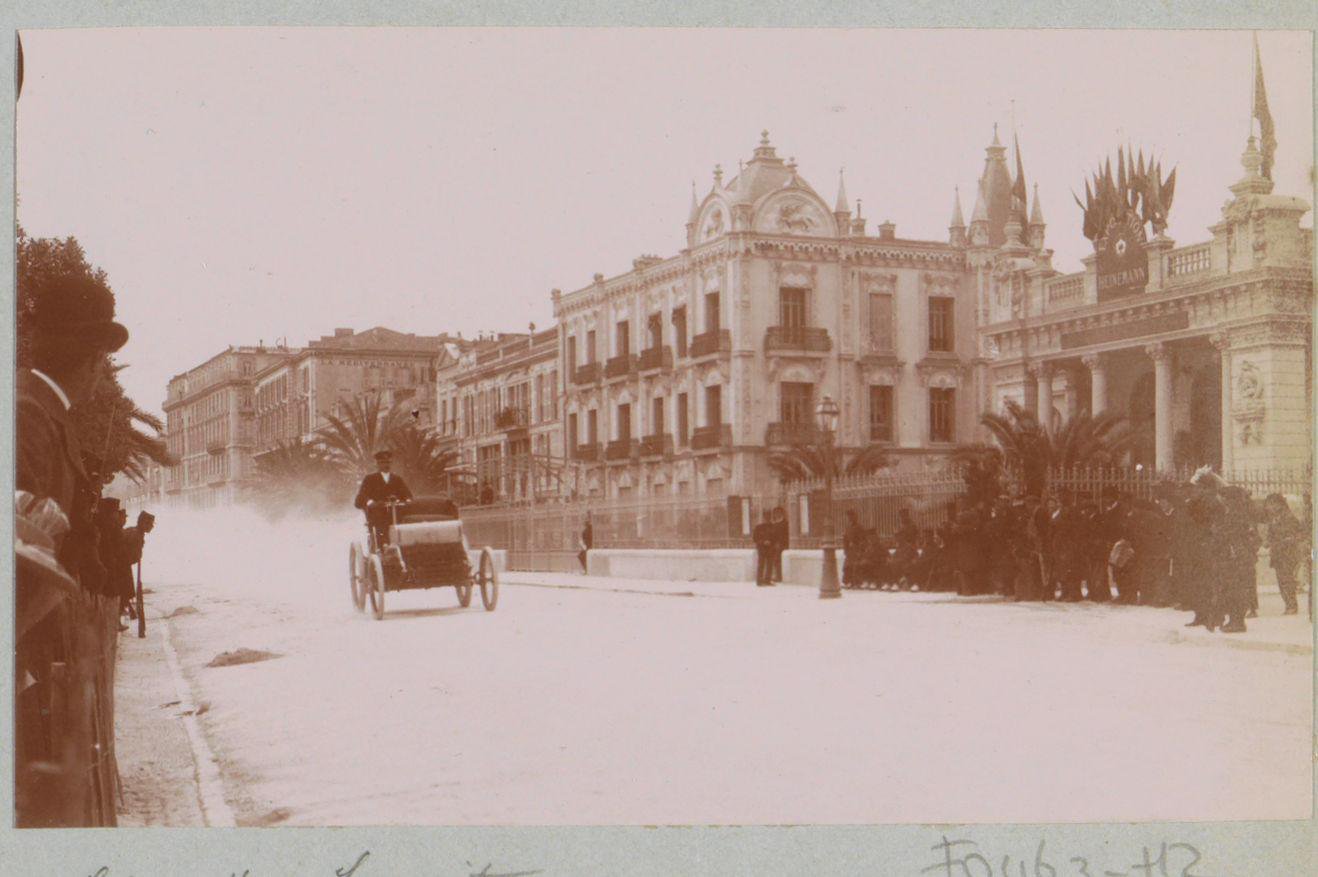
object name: photograph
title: Autocoureur Lemaître, deelnemer aan de Course du Mille, een race voor automobielen in Nice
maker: delizy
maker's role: manufacturer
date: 1899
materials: paper, photographic support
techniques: gelatin silver print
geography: nice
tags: motorcar racing, automobile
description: Onderdeel van Fotoalbum van een Franse amateurfotograaf met opnames van uitstapjes in Frankrijk, Spanje, België, Luxemburg en Nederland, de eerste automobielen en autoraces.